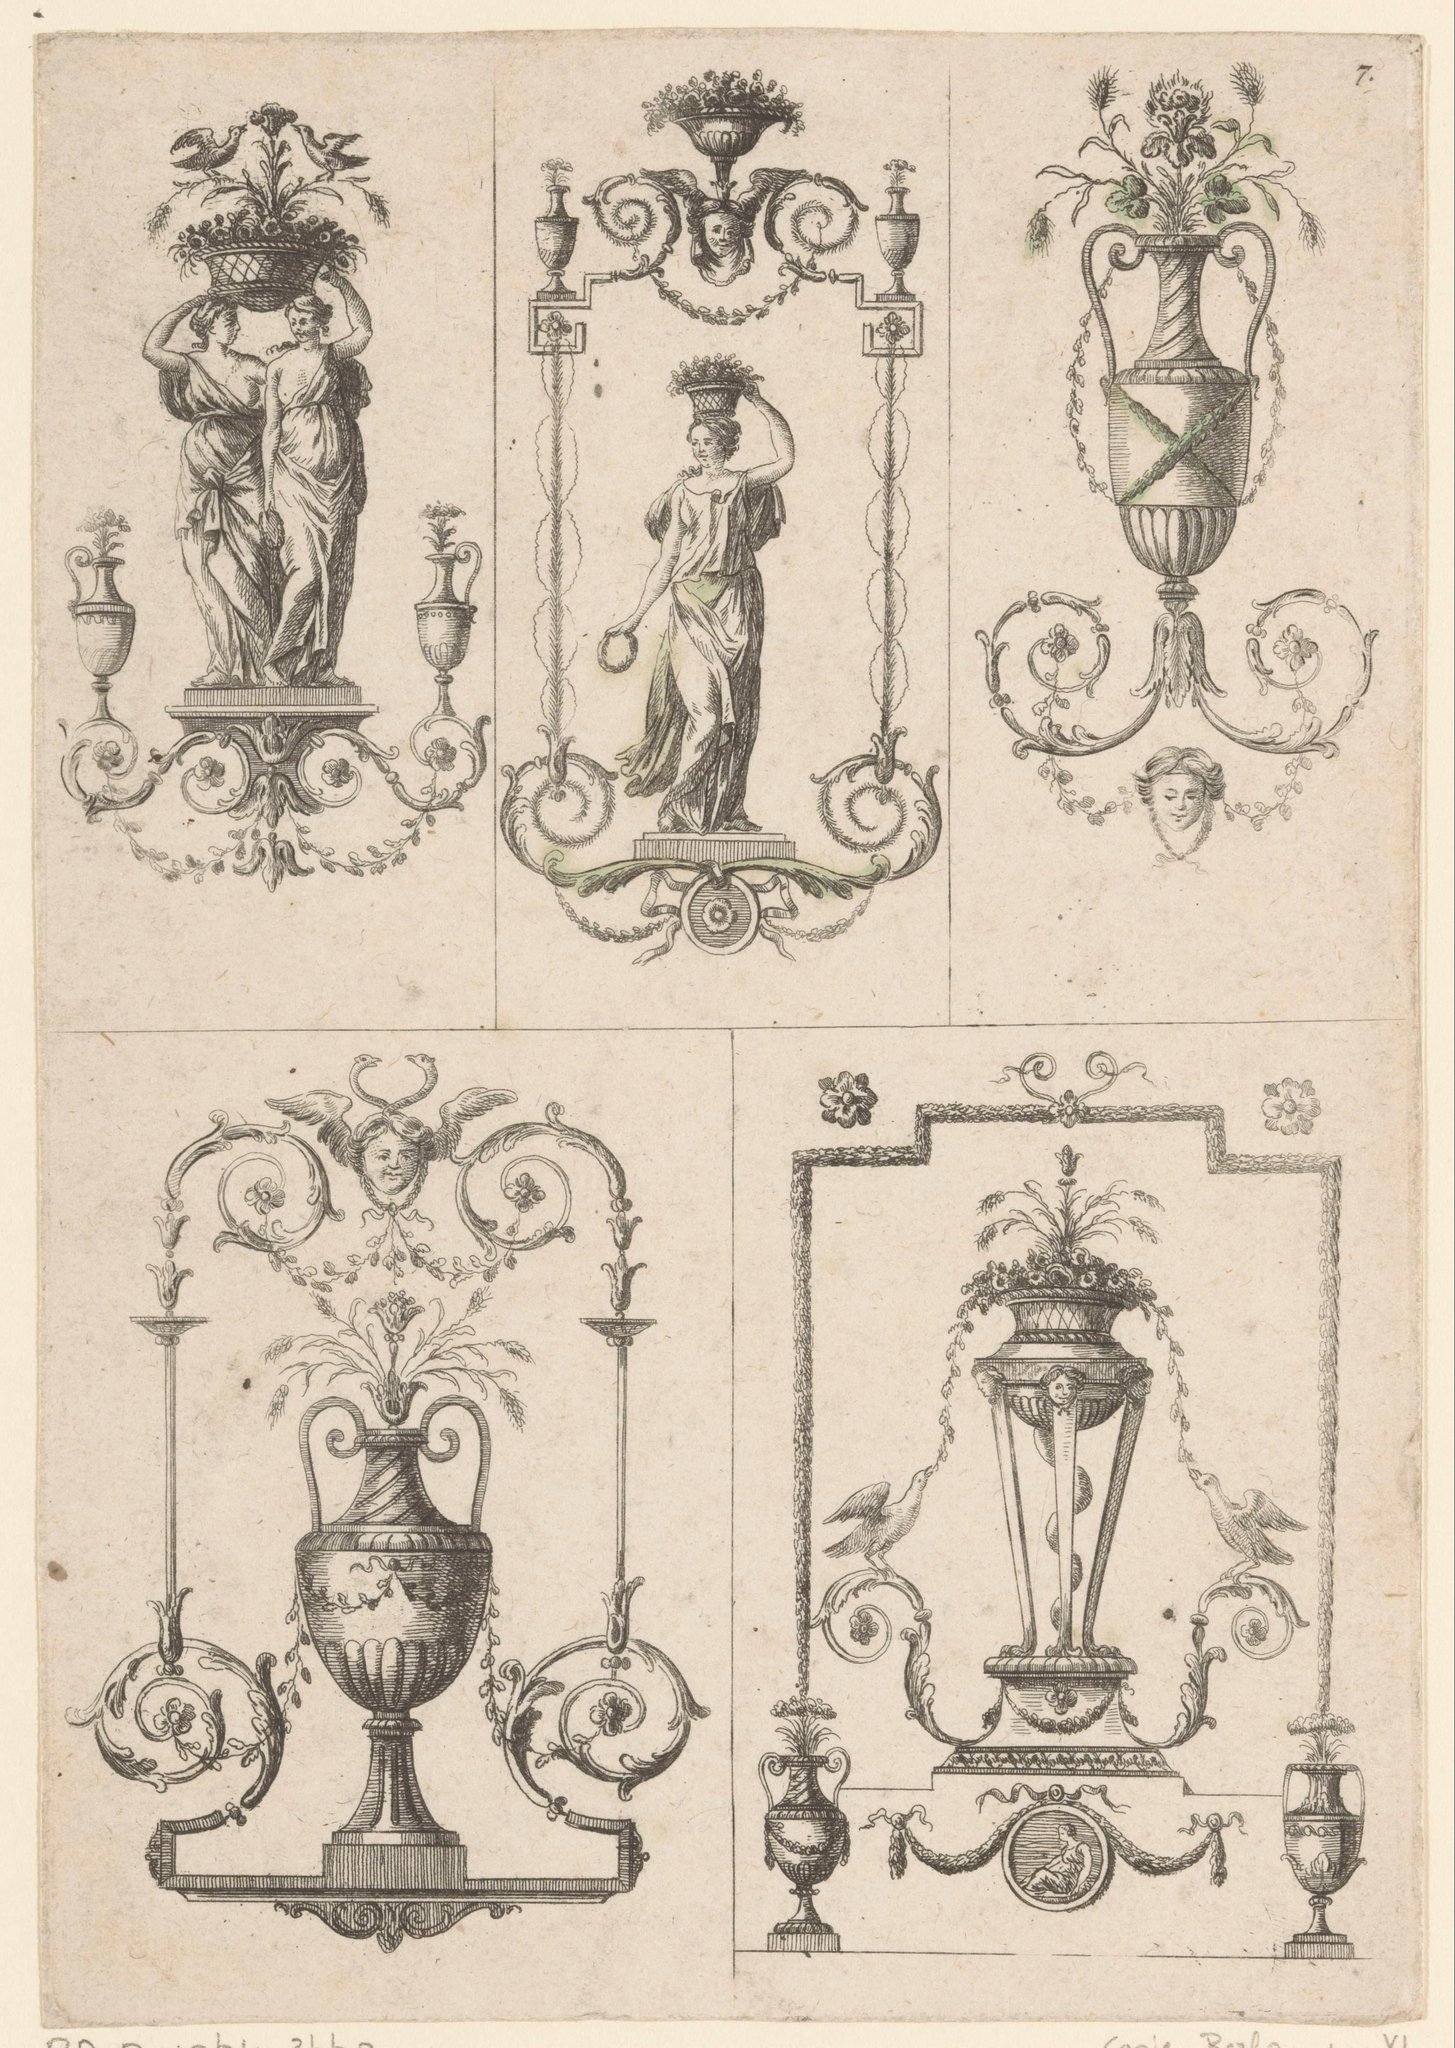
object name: ornament print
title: Arabesken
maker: kollmann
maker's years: 1700-1799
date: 1746-1800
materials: paper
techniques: etching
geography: paris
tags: ornament ~ arabesque, vase ~ ornament, standing figure - aa - female human figure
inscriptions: collector's mark: Lugt 2228, collector's mark: Lugt 2760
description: Vijf scènes met arabesken, staande vrouwen en vazen.